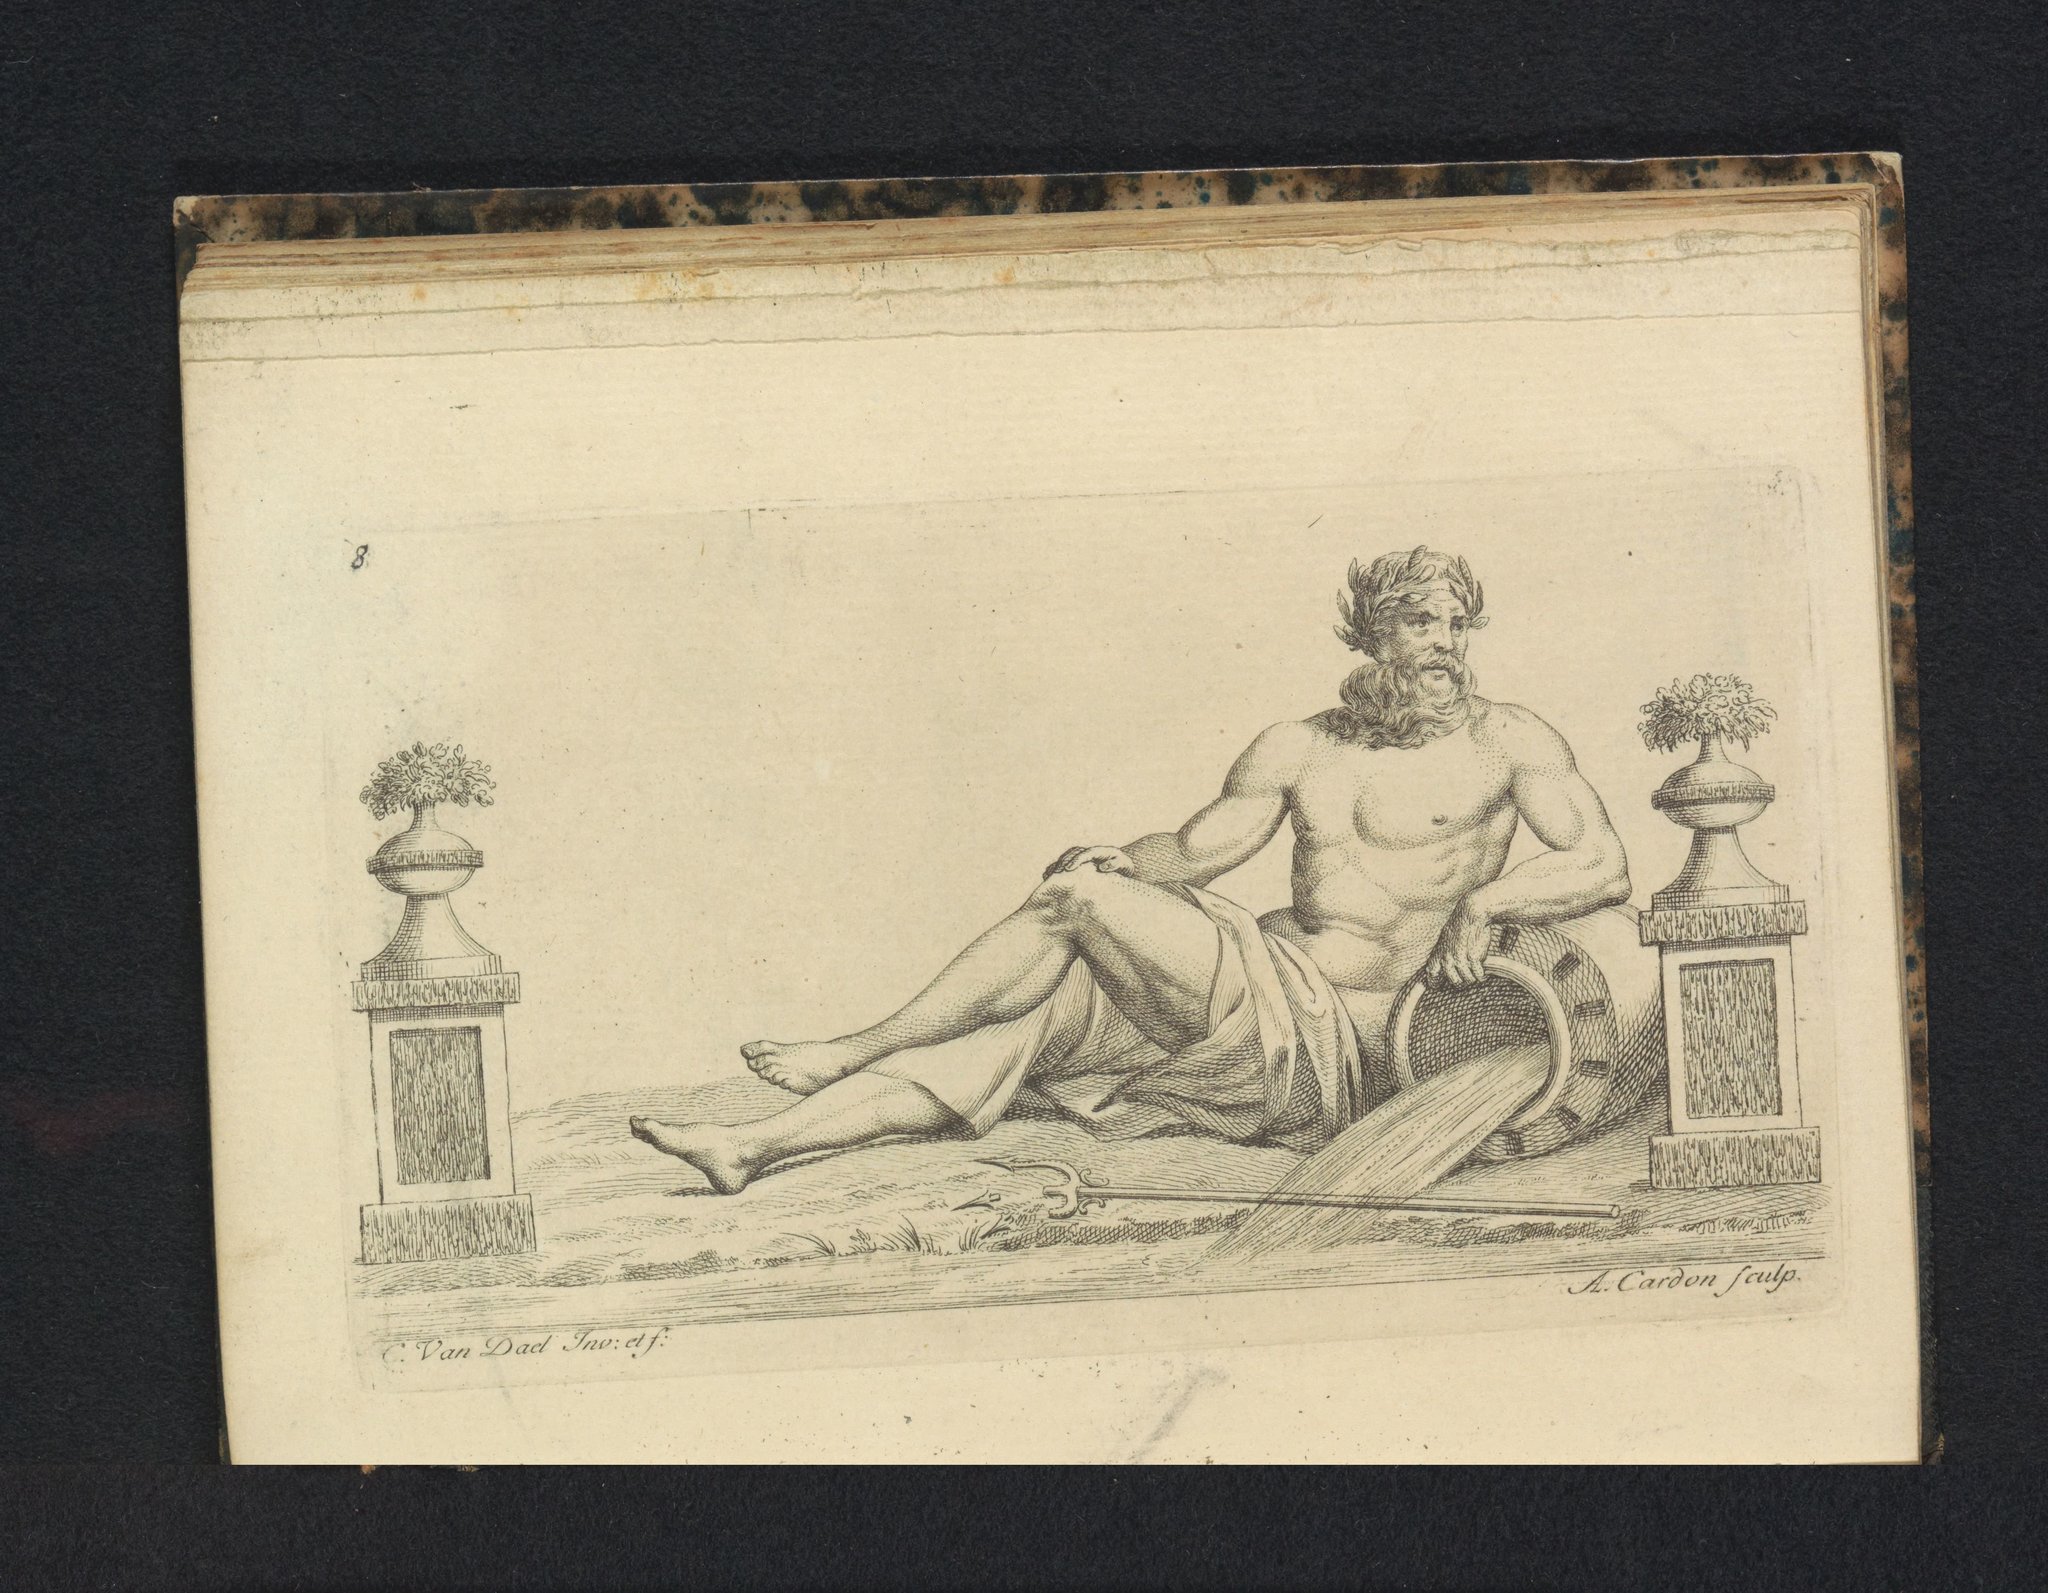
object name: print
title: Riviergod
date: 1772-1773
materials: paper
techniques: engraving, etching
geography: southern netherlands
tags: river personified, 'fiumi' (ripa), piece of sculpture, reproduction of a piece of sculpture (+ clay, sand, etc. ~ arts), antwerp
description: Sculptuur van een riviergod. Beeld gemaakt door Corneille van Dael, Guilleaume Roef en François Meulemeester op de Beestenmarkt. Genummerd linksboven in de plaat: 8. Onderdeel van de verzameling van figuren en beelden gemaakt van sneeuw in de straten van Antwerpen in januari 1772.